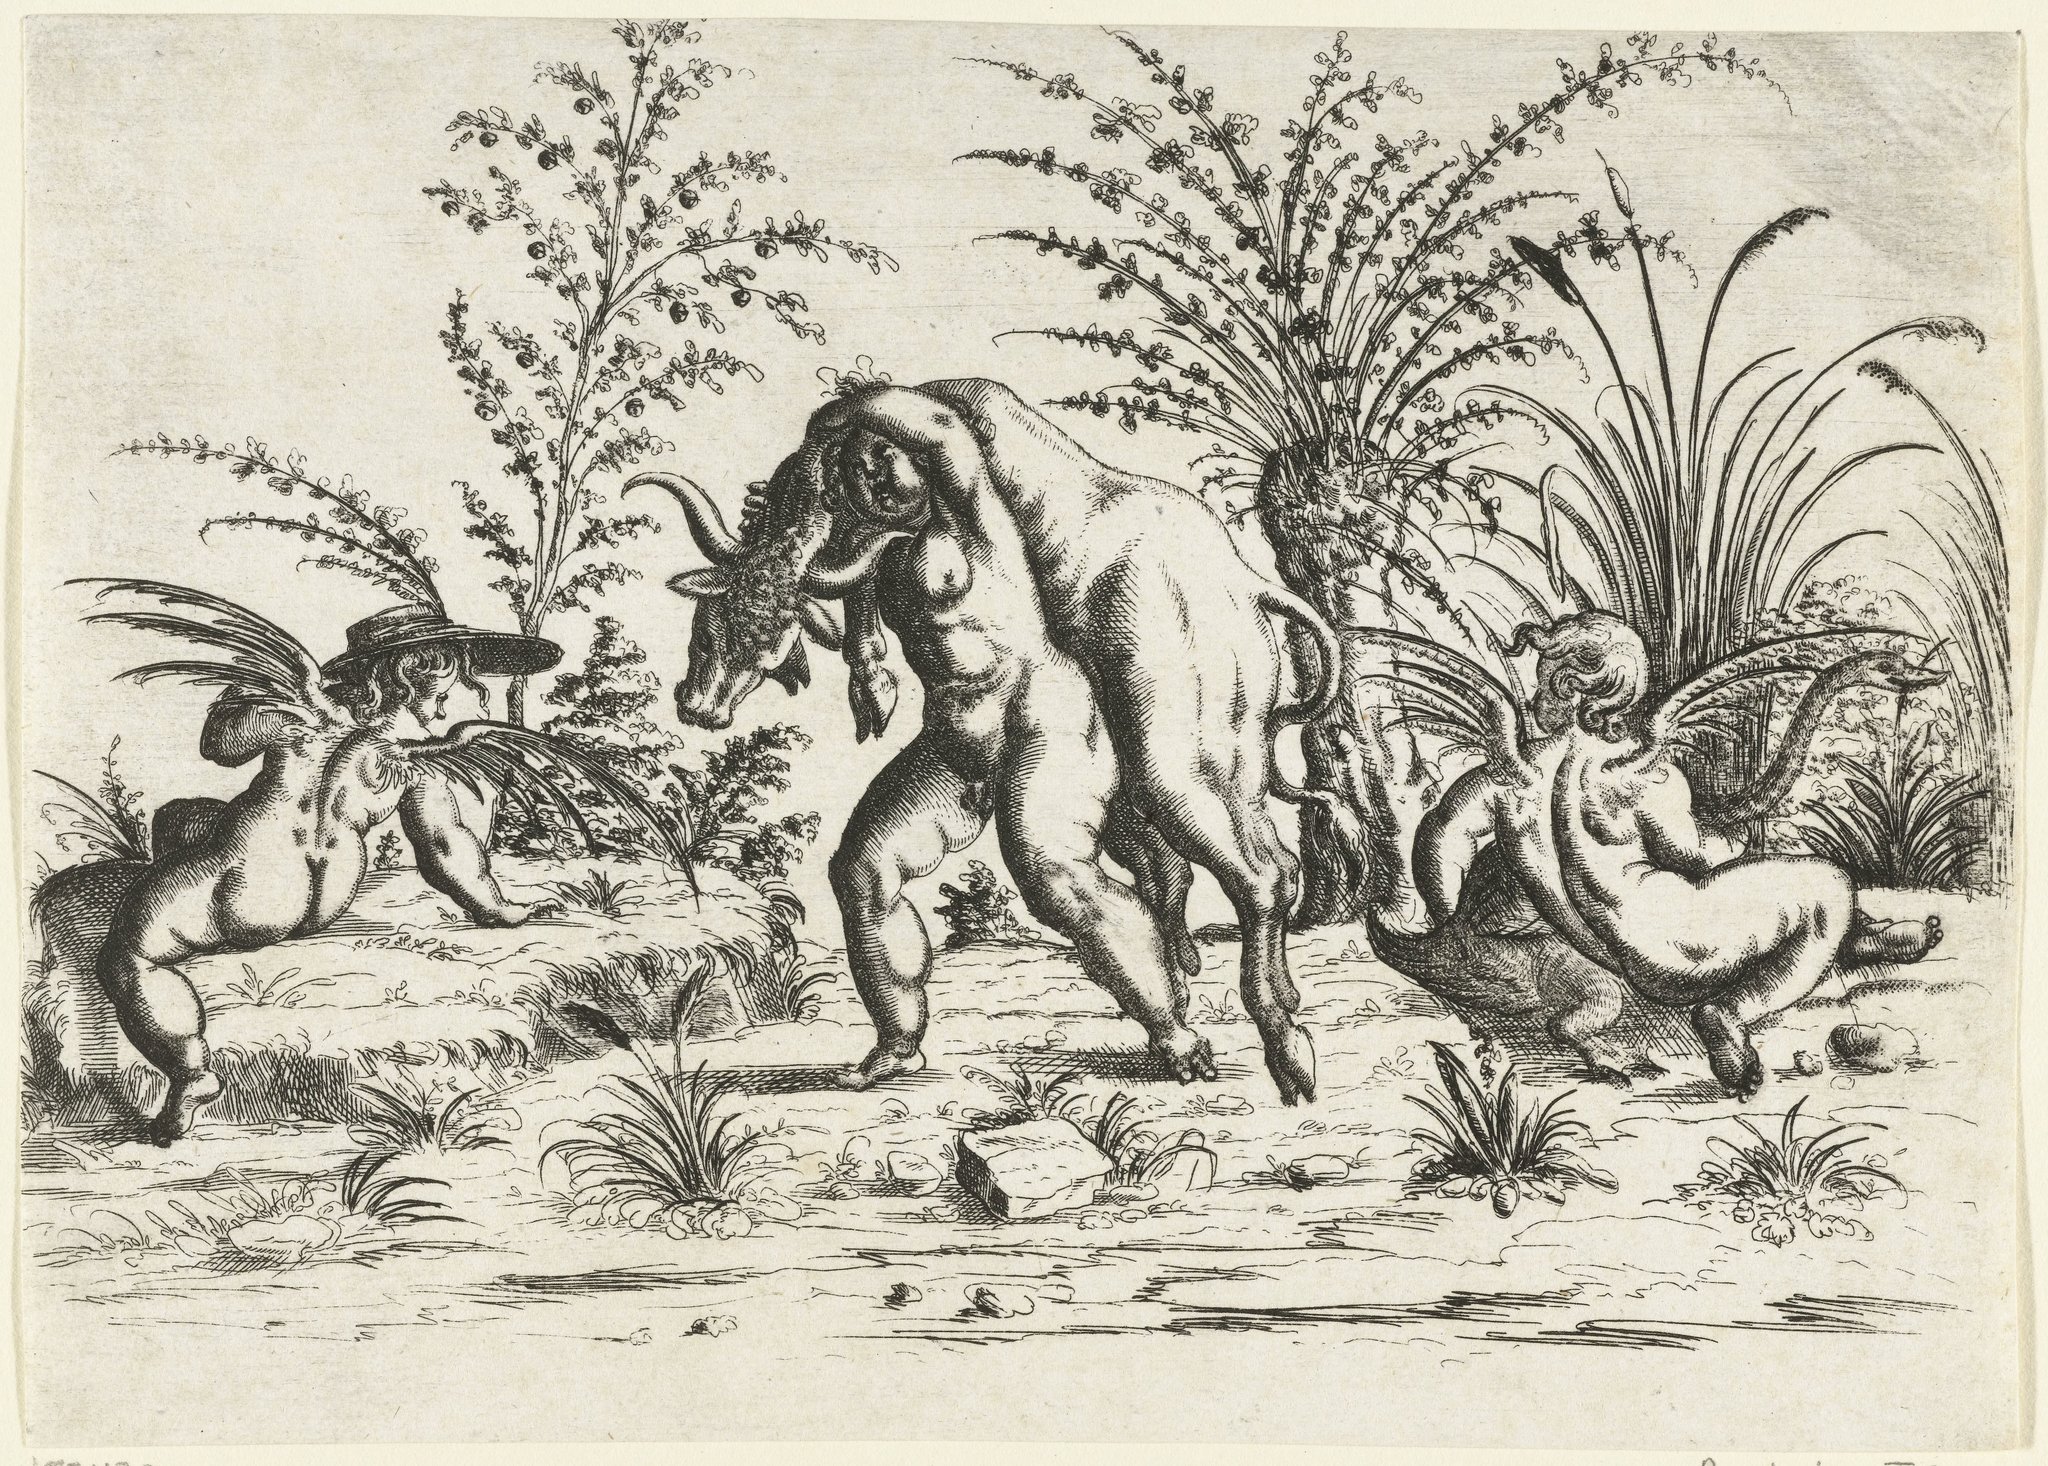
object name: ornament print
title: Landschap met drie putti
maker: christoph jamnitzer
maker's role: draughtsman, goldsmith, print maker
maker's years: 1563-1618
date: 1573-1610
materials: paper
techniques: etching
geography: germany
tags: cow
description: In het midden versleept een putto op zijn schouders een koe. Blad uit een serie vlakdecoraties met grotesken, cartouches, ovalen, mascarons, putti en fantastische wezens. De serie bestaat uit drie titelbladen, twee tekstbladen met de opdracht en het voorwoord en 60 bladen, verdeeld over drie boeken.